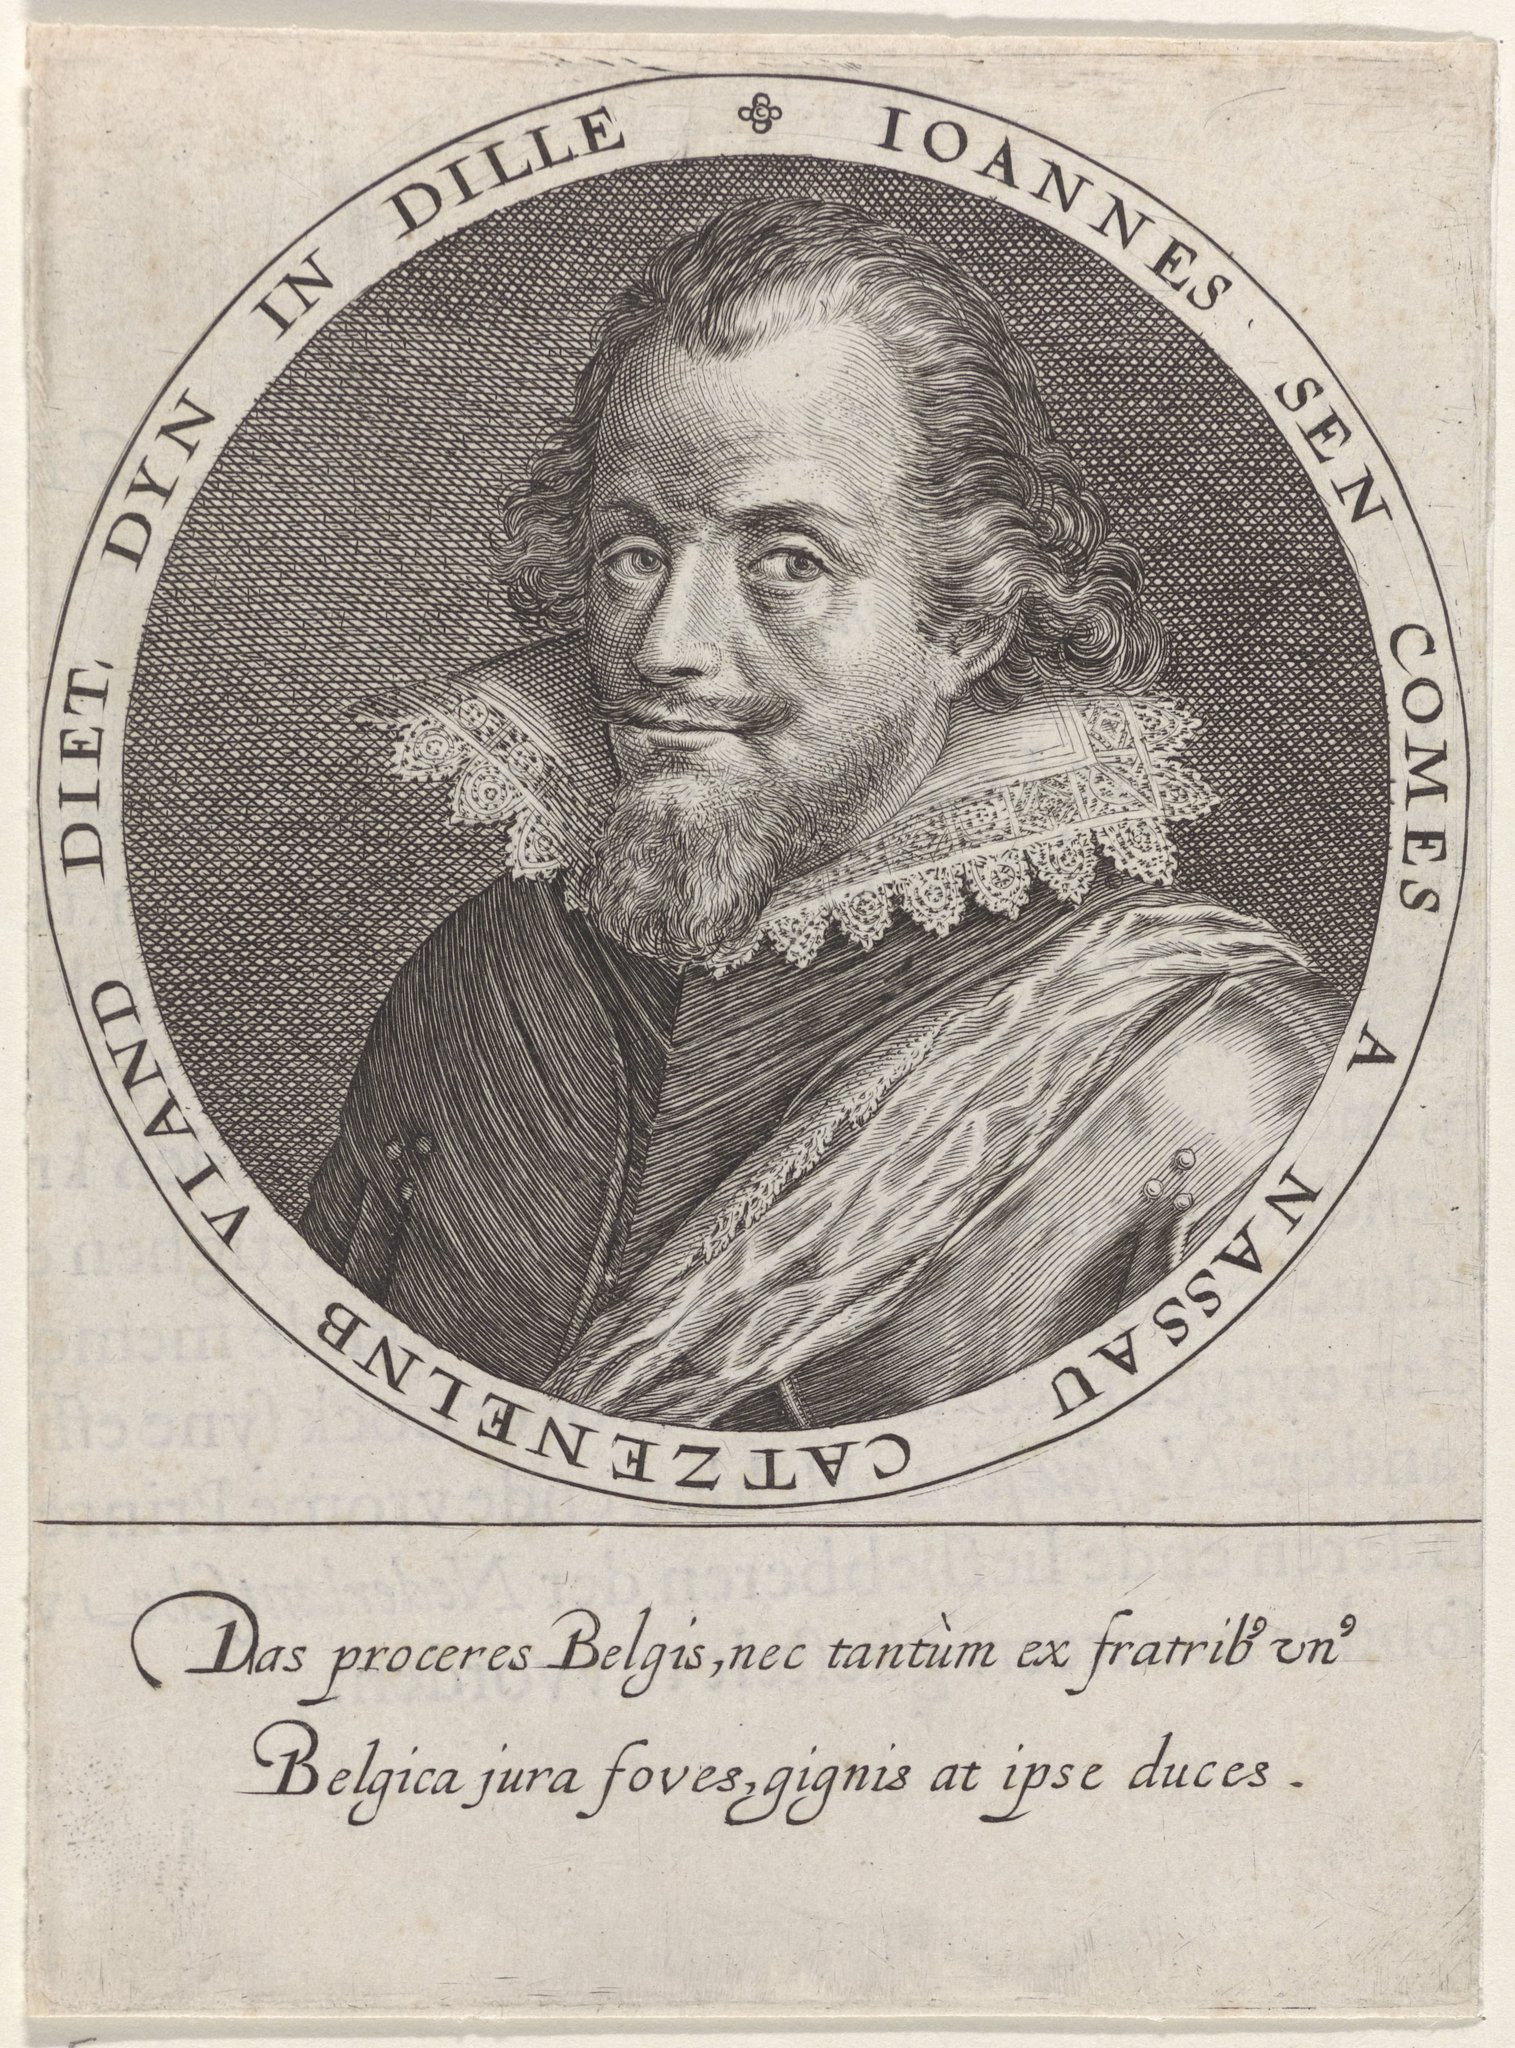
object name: print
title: Portret van Johan VII, graaf van Nassau-Siegen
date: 1615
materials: paper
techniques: engraving, etching, letterpress printing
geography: utrecht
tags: dillenburg, siegen, johan vii graaf van nassau-siegen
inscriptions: collector's mark: Lugt 963, collector's mark: Lugt 2228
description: De hier vermelde titel verwijst naar de hoogst verkregen titel van de geportretteerde, niet per se naar de titel die de geportretteerde op deze voorstelling draagt. Prent uit: Buchelius, Arnoldus. Nassovischen Oraignen-boom, daer by ghevoecht, de conterfeytsels der voornaemster helden. = Malus Aurantius Nassovicus. Utrecht: Salomon de Roy, 1615.